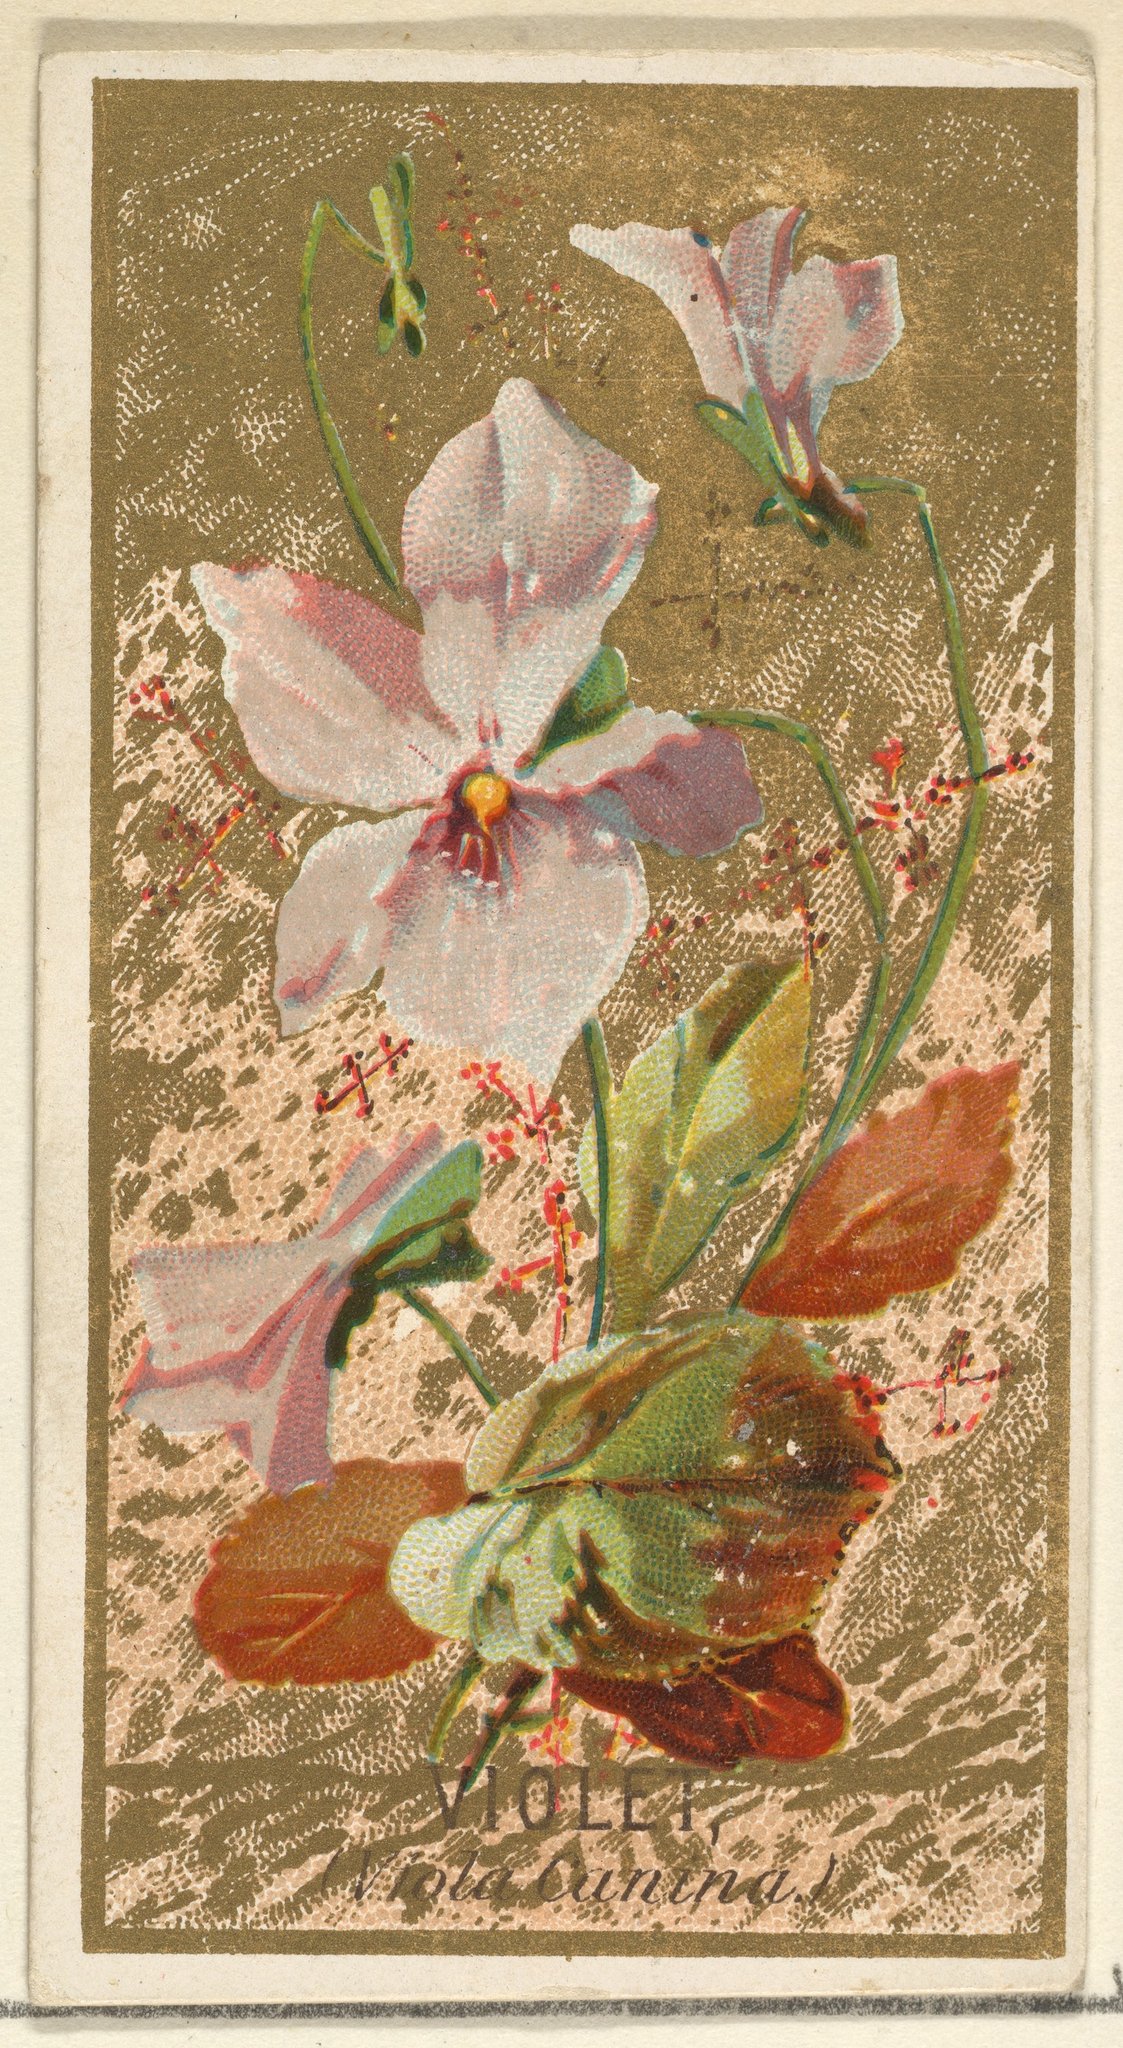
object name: print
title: Violet (Viola Canina), from the Flowers series for Old Judge Cigarettes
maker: goodwin & company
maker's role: publisher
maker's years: 1850-1950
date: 1890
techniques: color lithograph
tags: violets